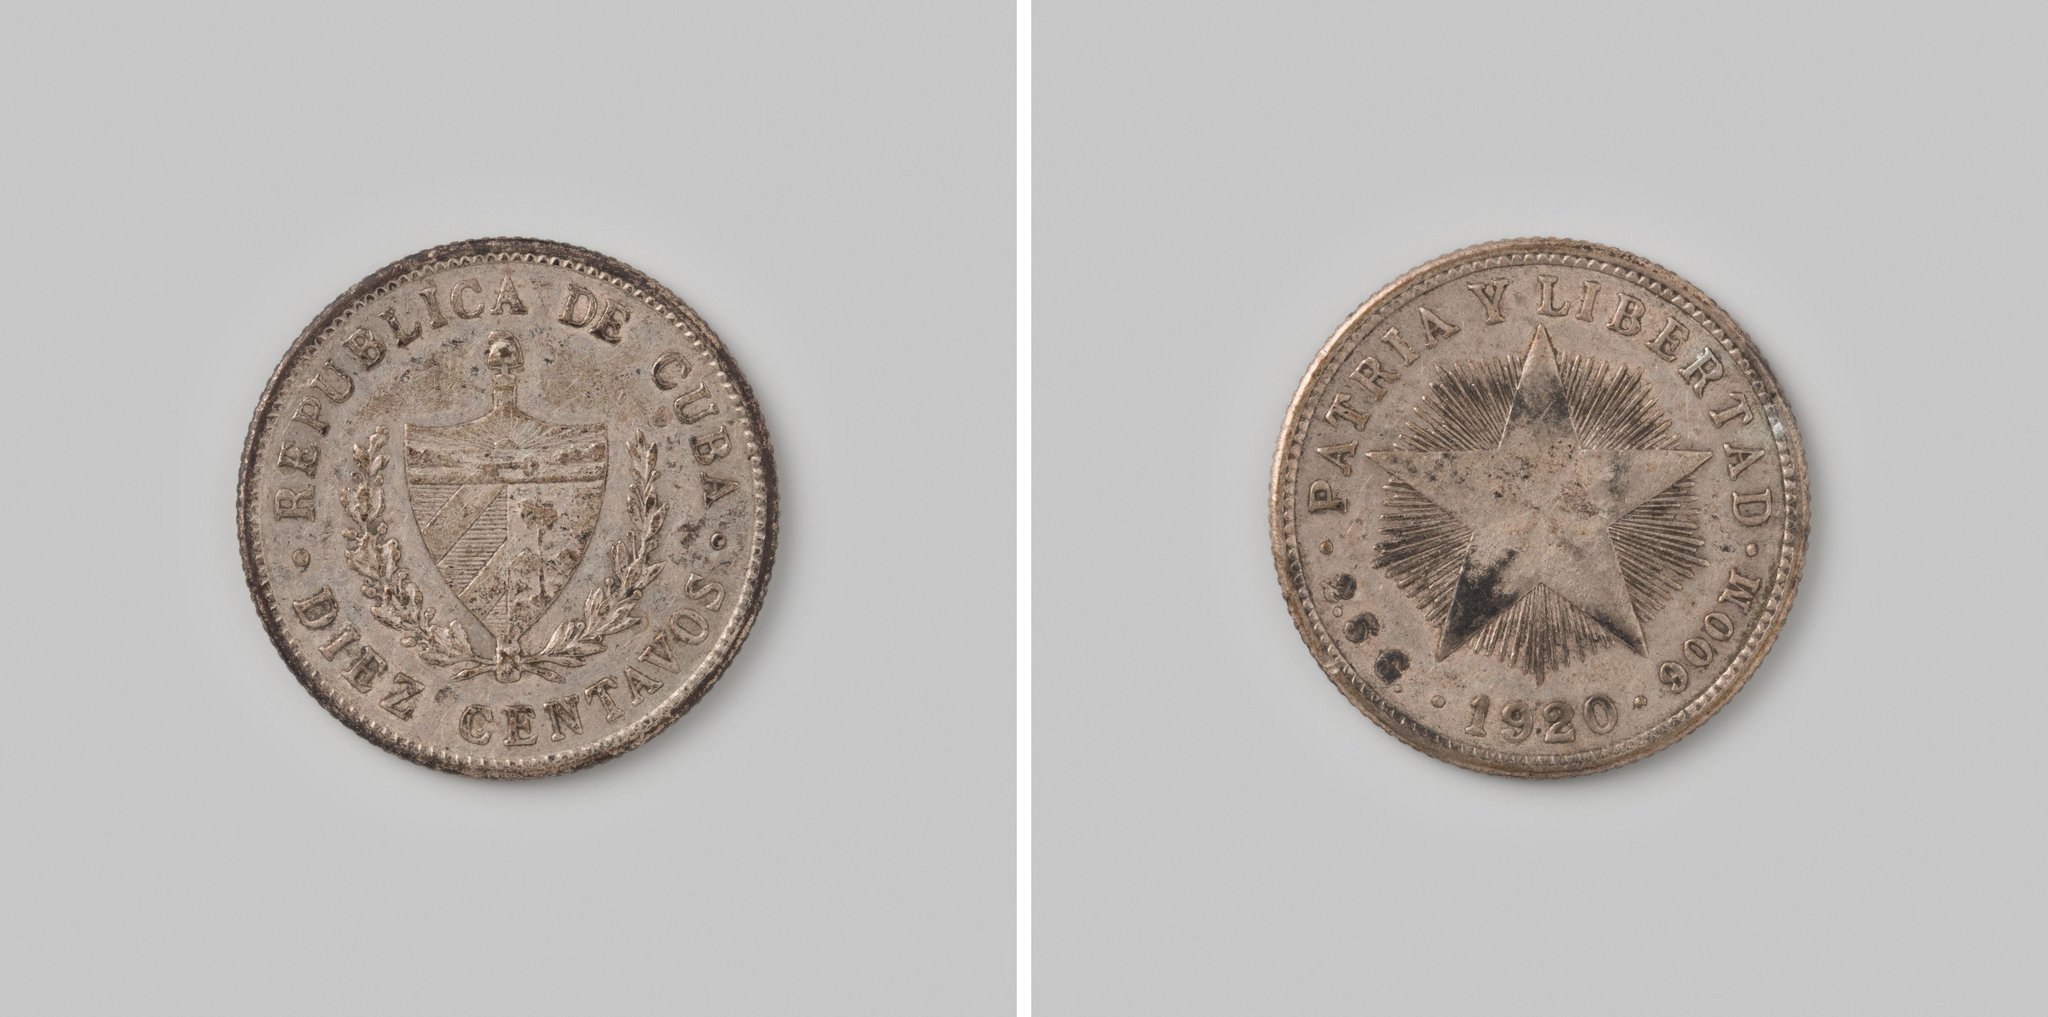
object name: coin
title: 10 centavos uit Cuba, 1920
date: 1920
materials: silver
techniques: striking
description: Zilveren munt. Voorzijde: tussen twee samengebonden takken wapenschild, waarboven vrijheidshoed. Daaronder waarde-aanduiding. Keerzijde: vijfpuntige ster met stralen, Onderaan: jaartal tussen gewichts- en gehalte-aanduiding. Kartelrand.